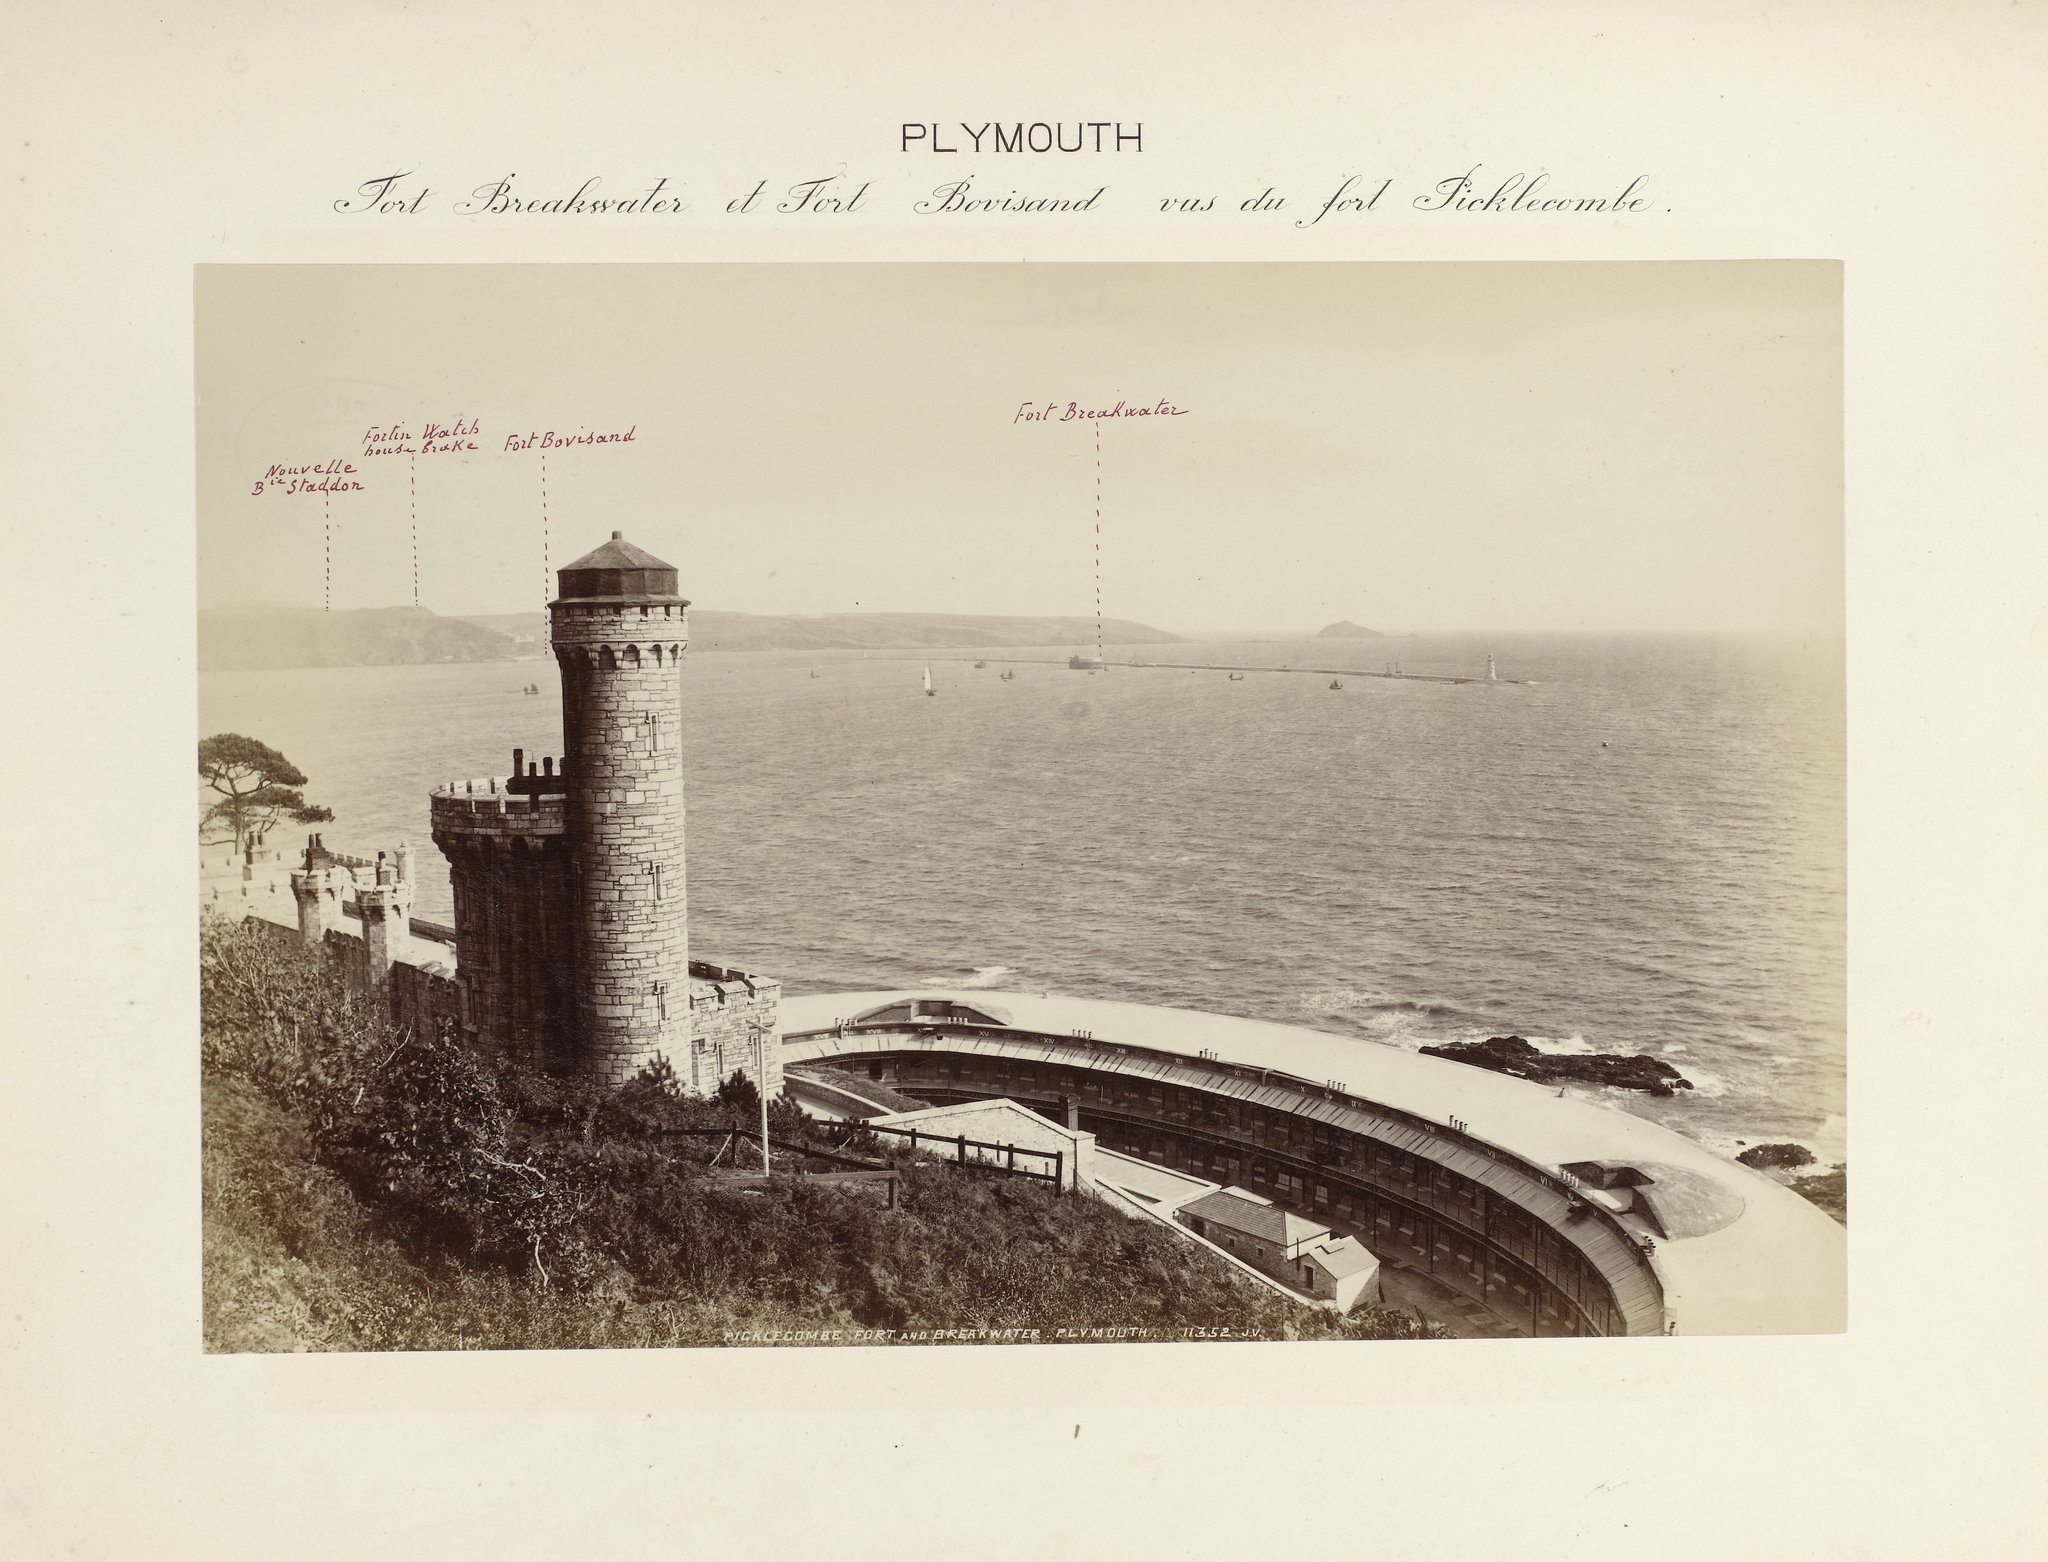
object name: photograph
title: Angleterre. Défense des côtes. Reconaissance de 1891. Photographies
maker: james valentine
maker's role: fotograaf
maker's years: 1815-1880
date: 1891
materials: cardboard, paper, photographic support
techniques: albumen print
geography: great britain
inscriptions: annotation: ‘Nouvelle B[atter]ie Staddon // Fortin Watch / house brake // Fort Bovisand // Fort Breakwater’, inscription: ‘PICKLECOMBE FORT AND BREAKWATER . PLYMOUTH. 11352 J.V.’, inscription: ‘PLYMOUTH / Fort Breakwater et Fort Bovisand vus du fort Picklecombe’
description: Foto uit een album met 35 topografische foto's van Britse kustplaatsen, waarop in pen militaire verdedigingswerken zijn aangegeven door een Franse militair.